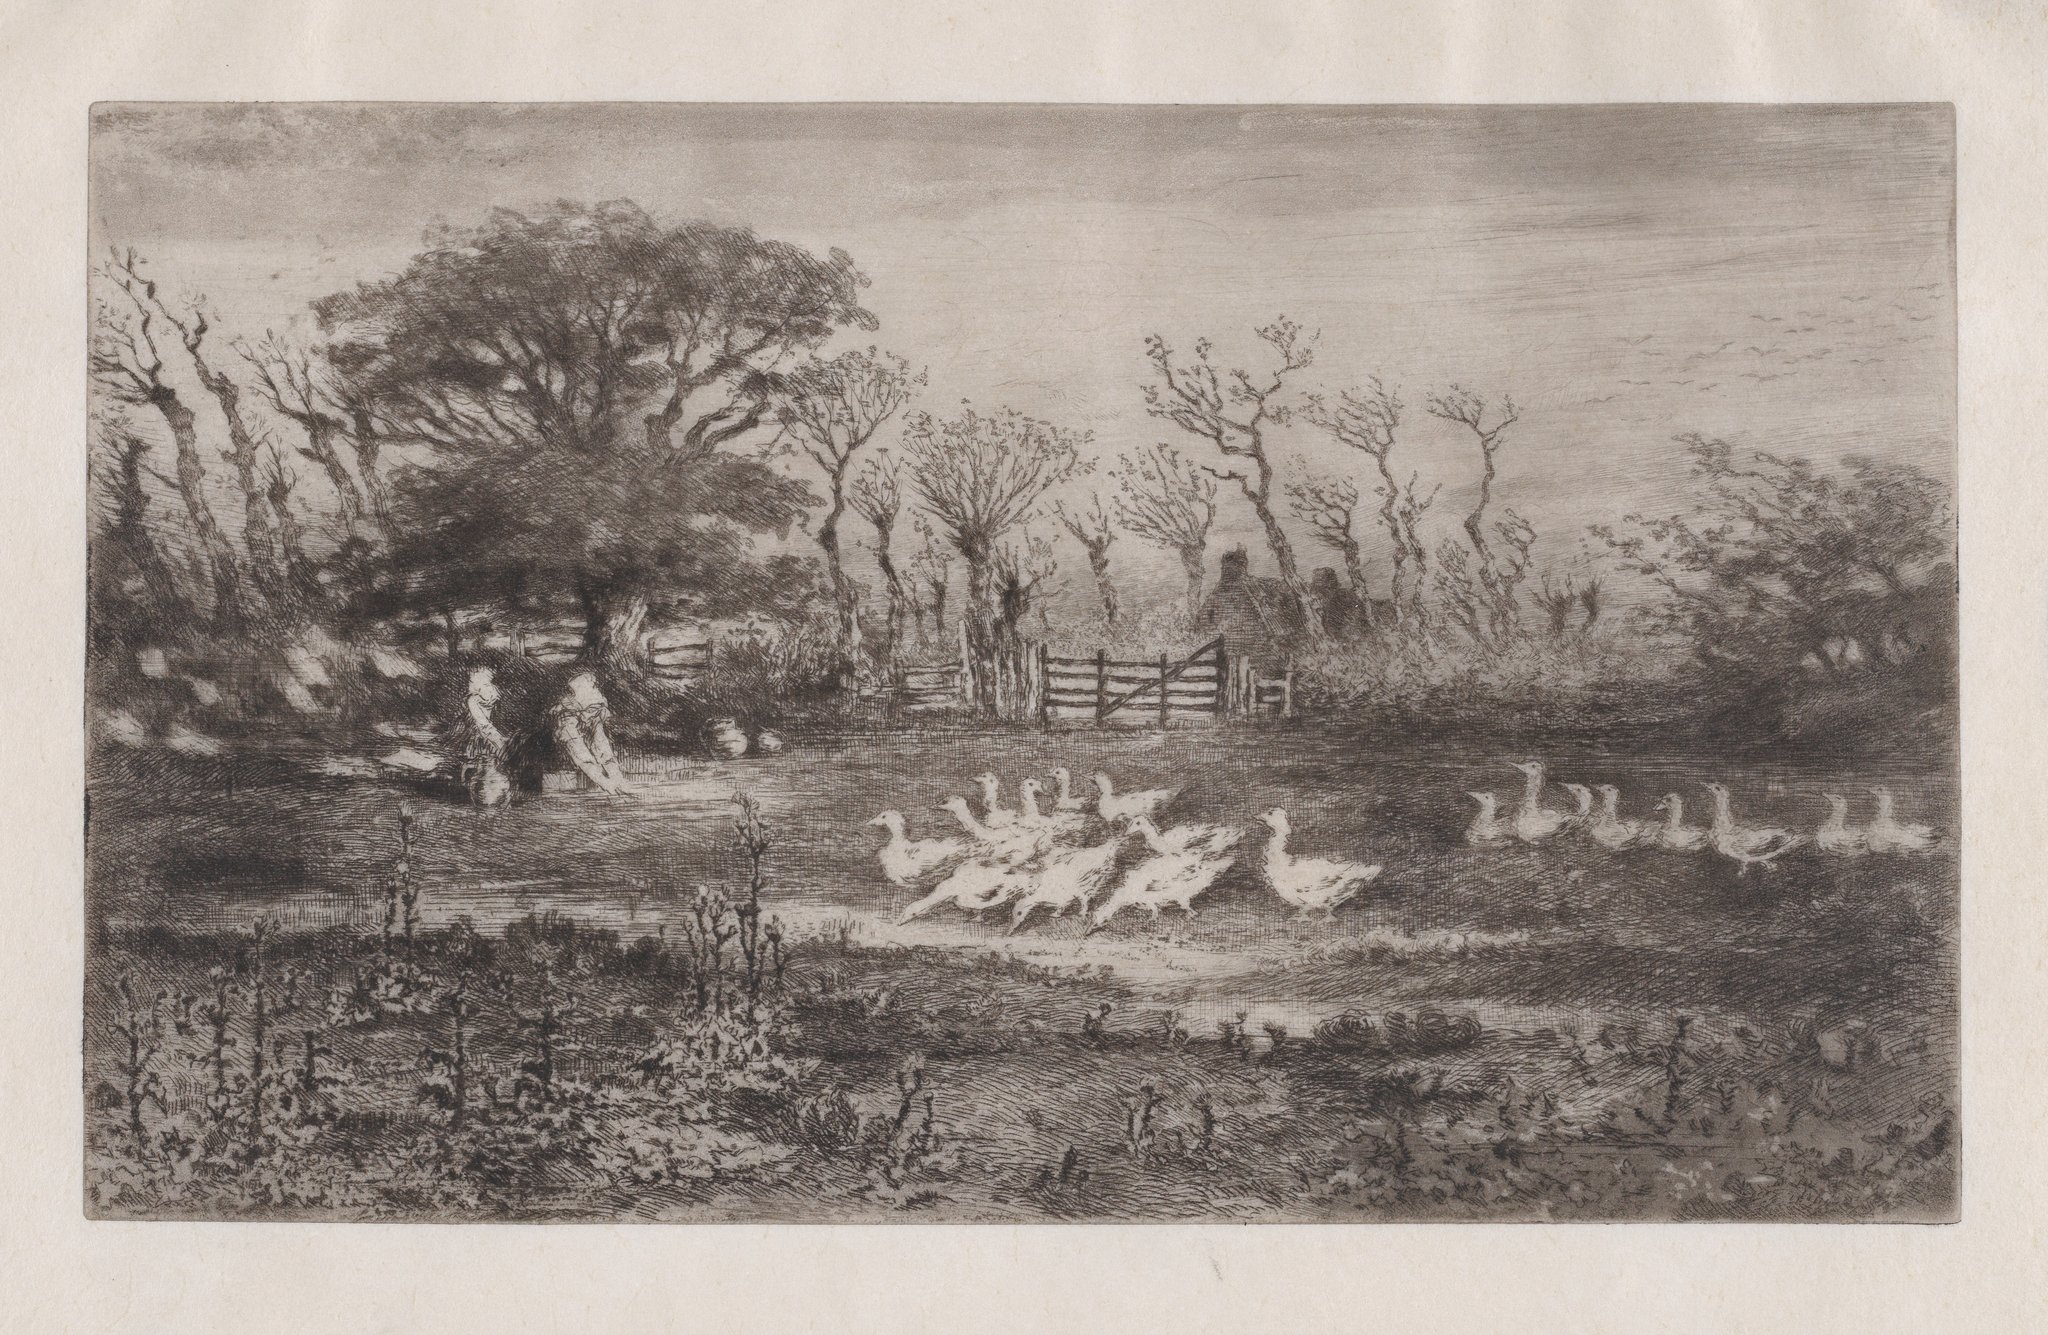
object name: print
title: Geese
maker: félix-hilaire buhot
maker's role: artist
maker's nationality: french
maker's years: 1847-1898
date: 1860-1898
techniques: aquatint, drypoint, etching, roulette